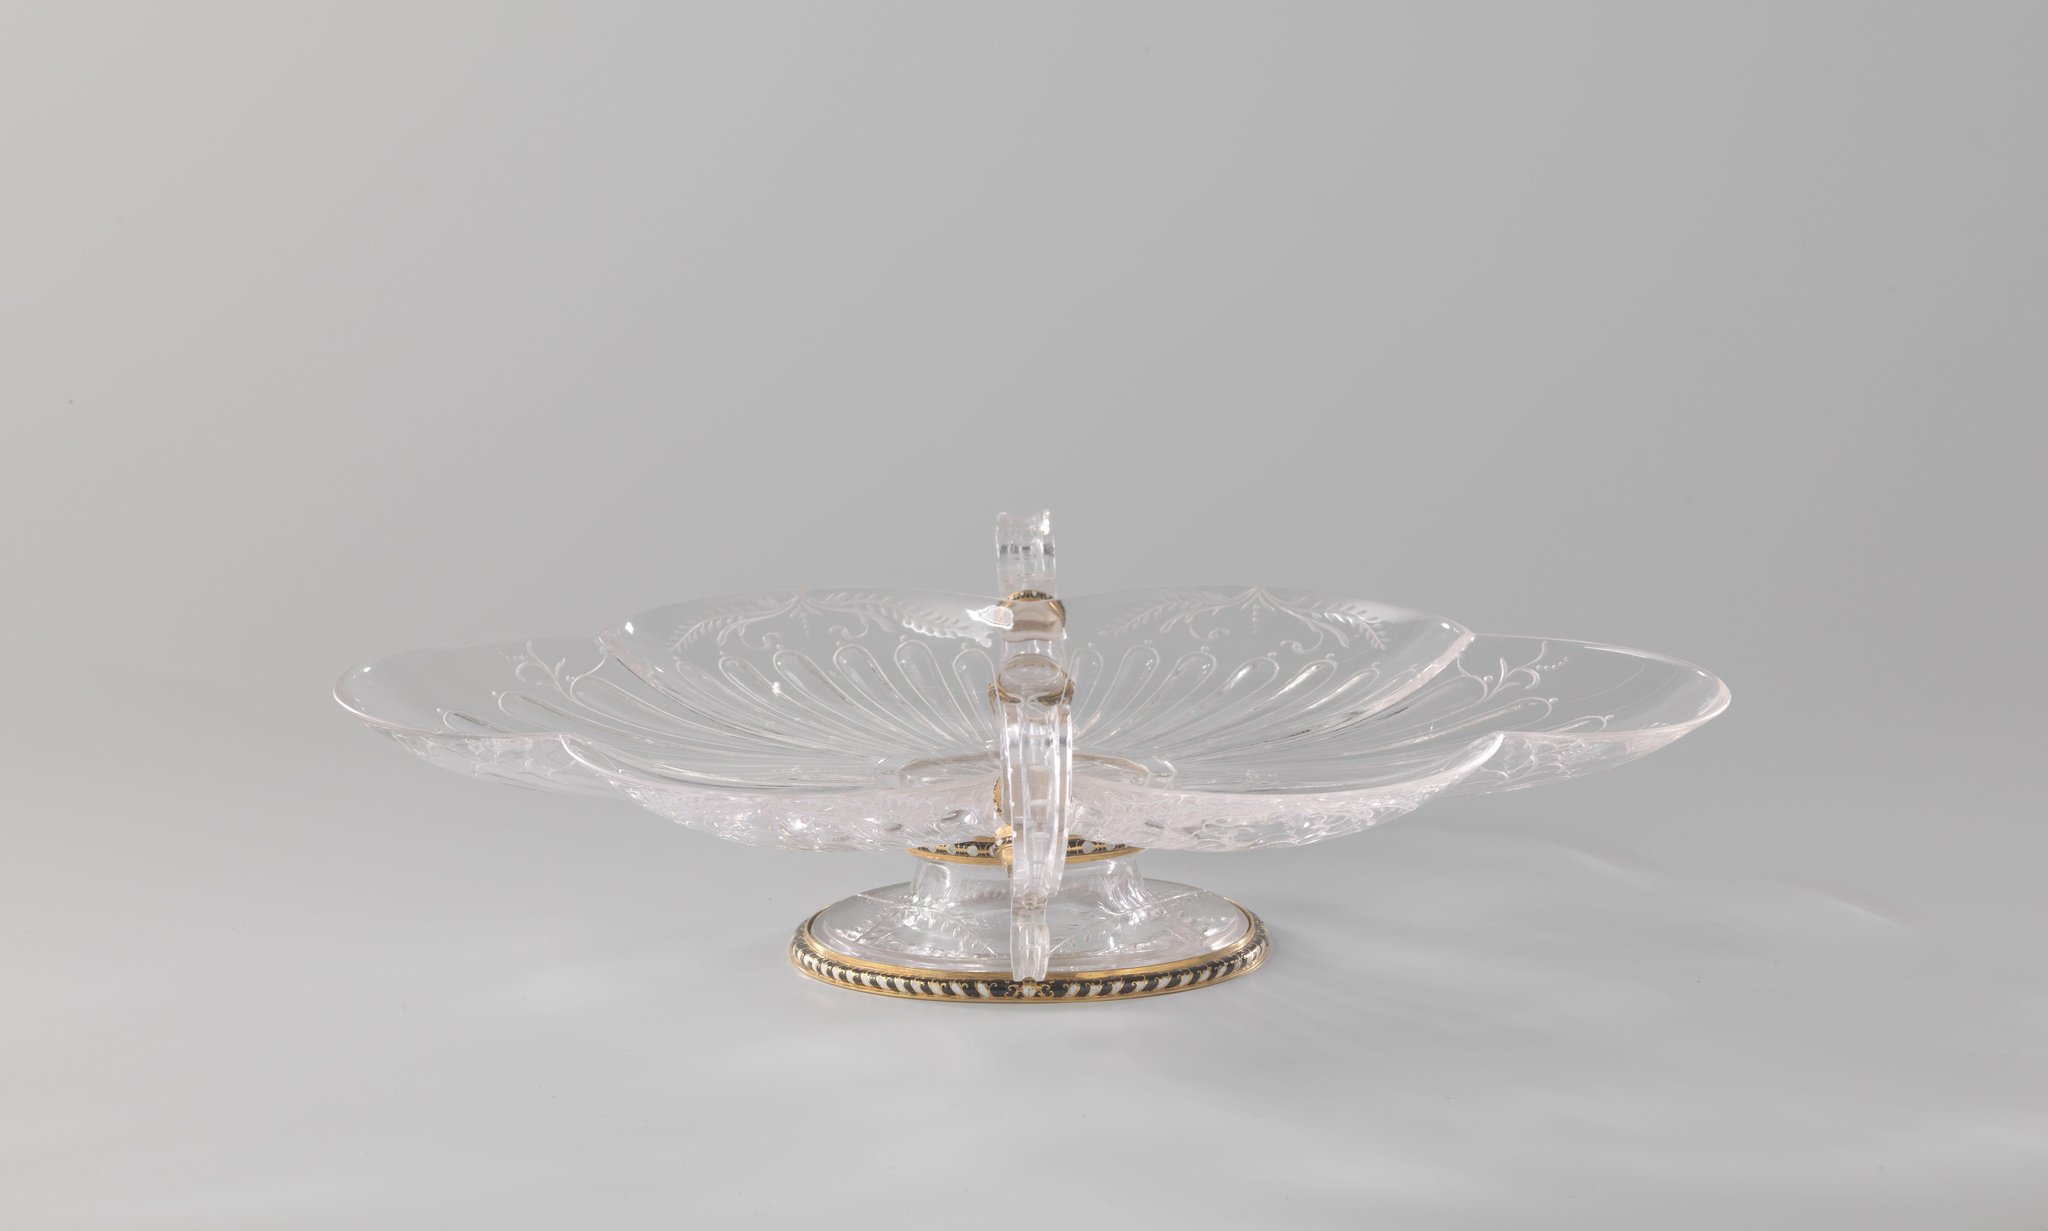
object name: dish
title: Schaal, ovaal en zeslobbig, van bergkristal. Twee S-vormige oren. Versiering van straalsgewijs geplaatste grodrons en enkele gegraveerde ranken en vogeltjes.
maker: Anonymous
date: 1630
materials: crystal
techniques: bergkristal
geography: northern italy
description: Footed dish. Rock crystal, gold and enamel. France or Northern Italy, c. 1630.